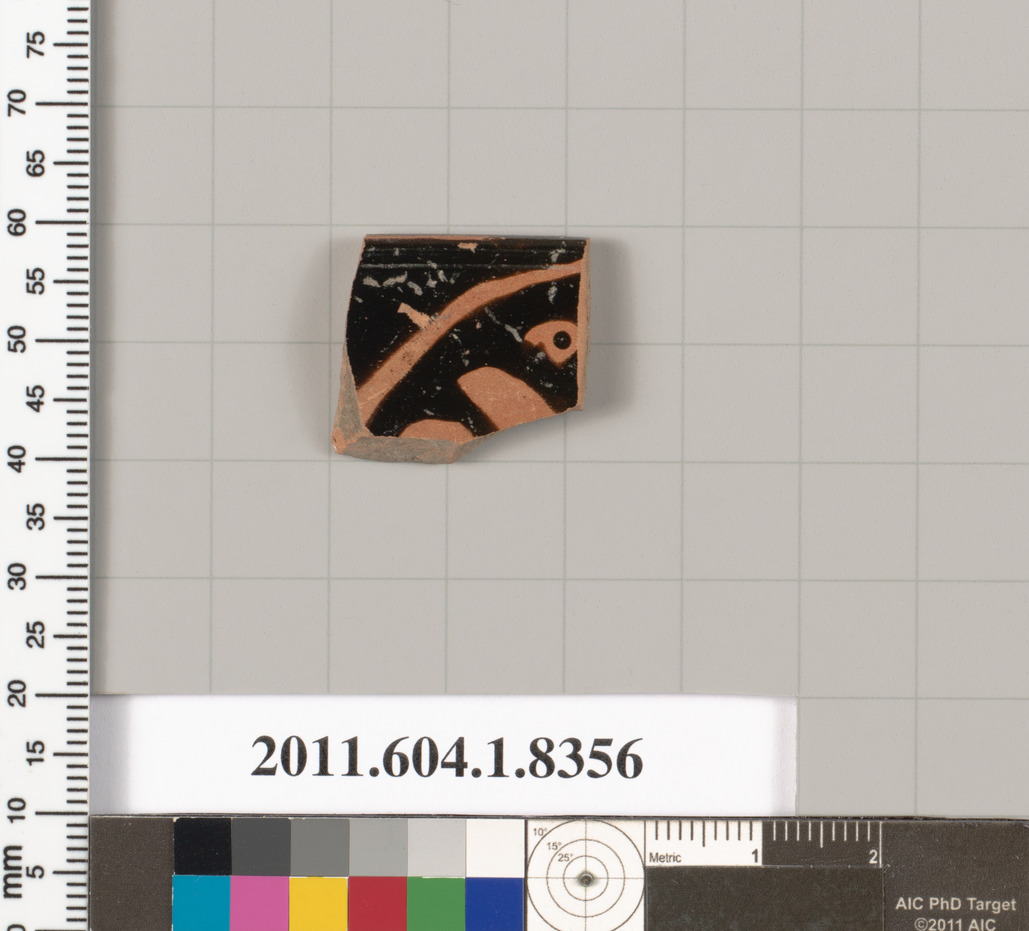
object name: kylix fragment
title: Terracotta rim fragment of a kylix (drinking cup)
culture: greek, attic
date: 425-401 BCE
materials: terracotta